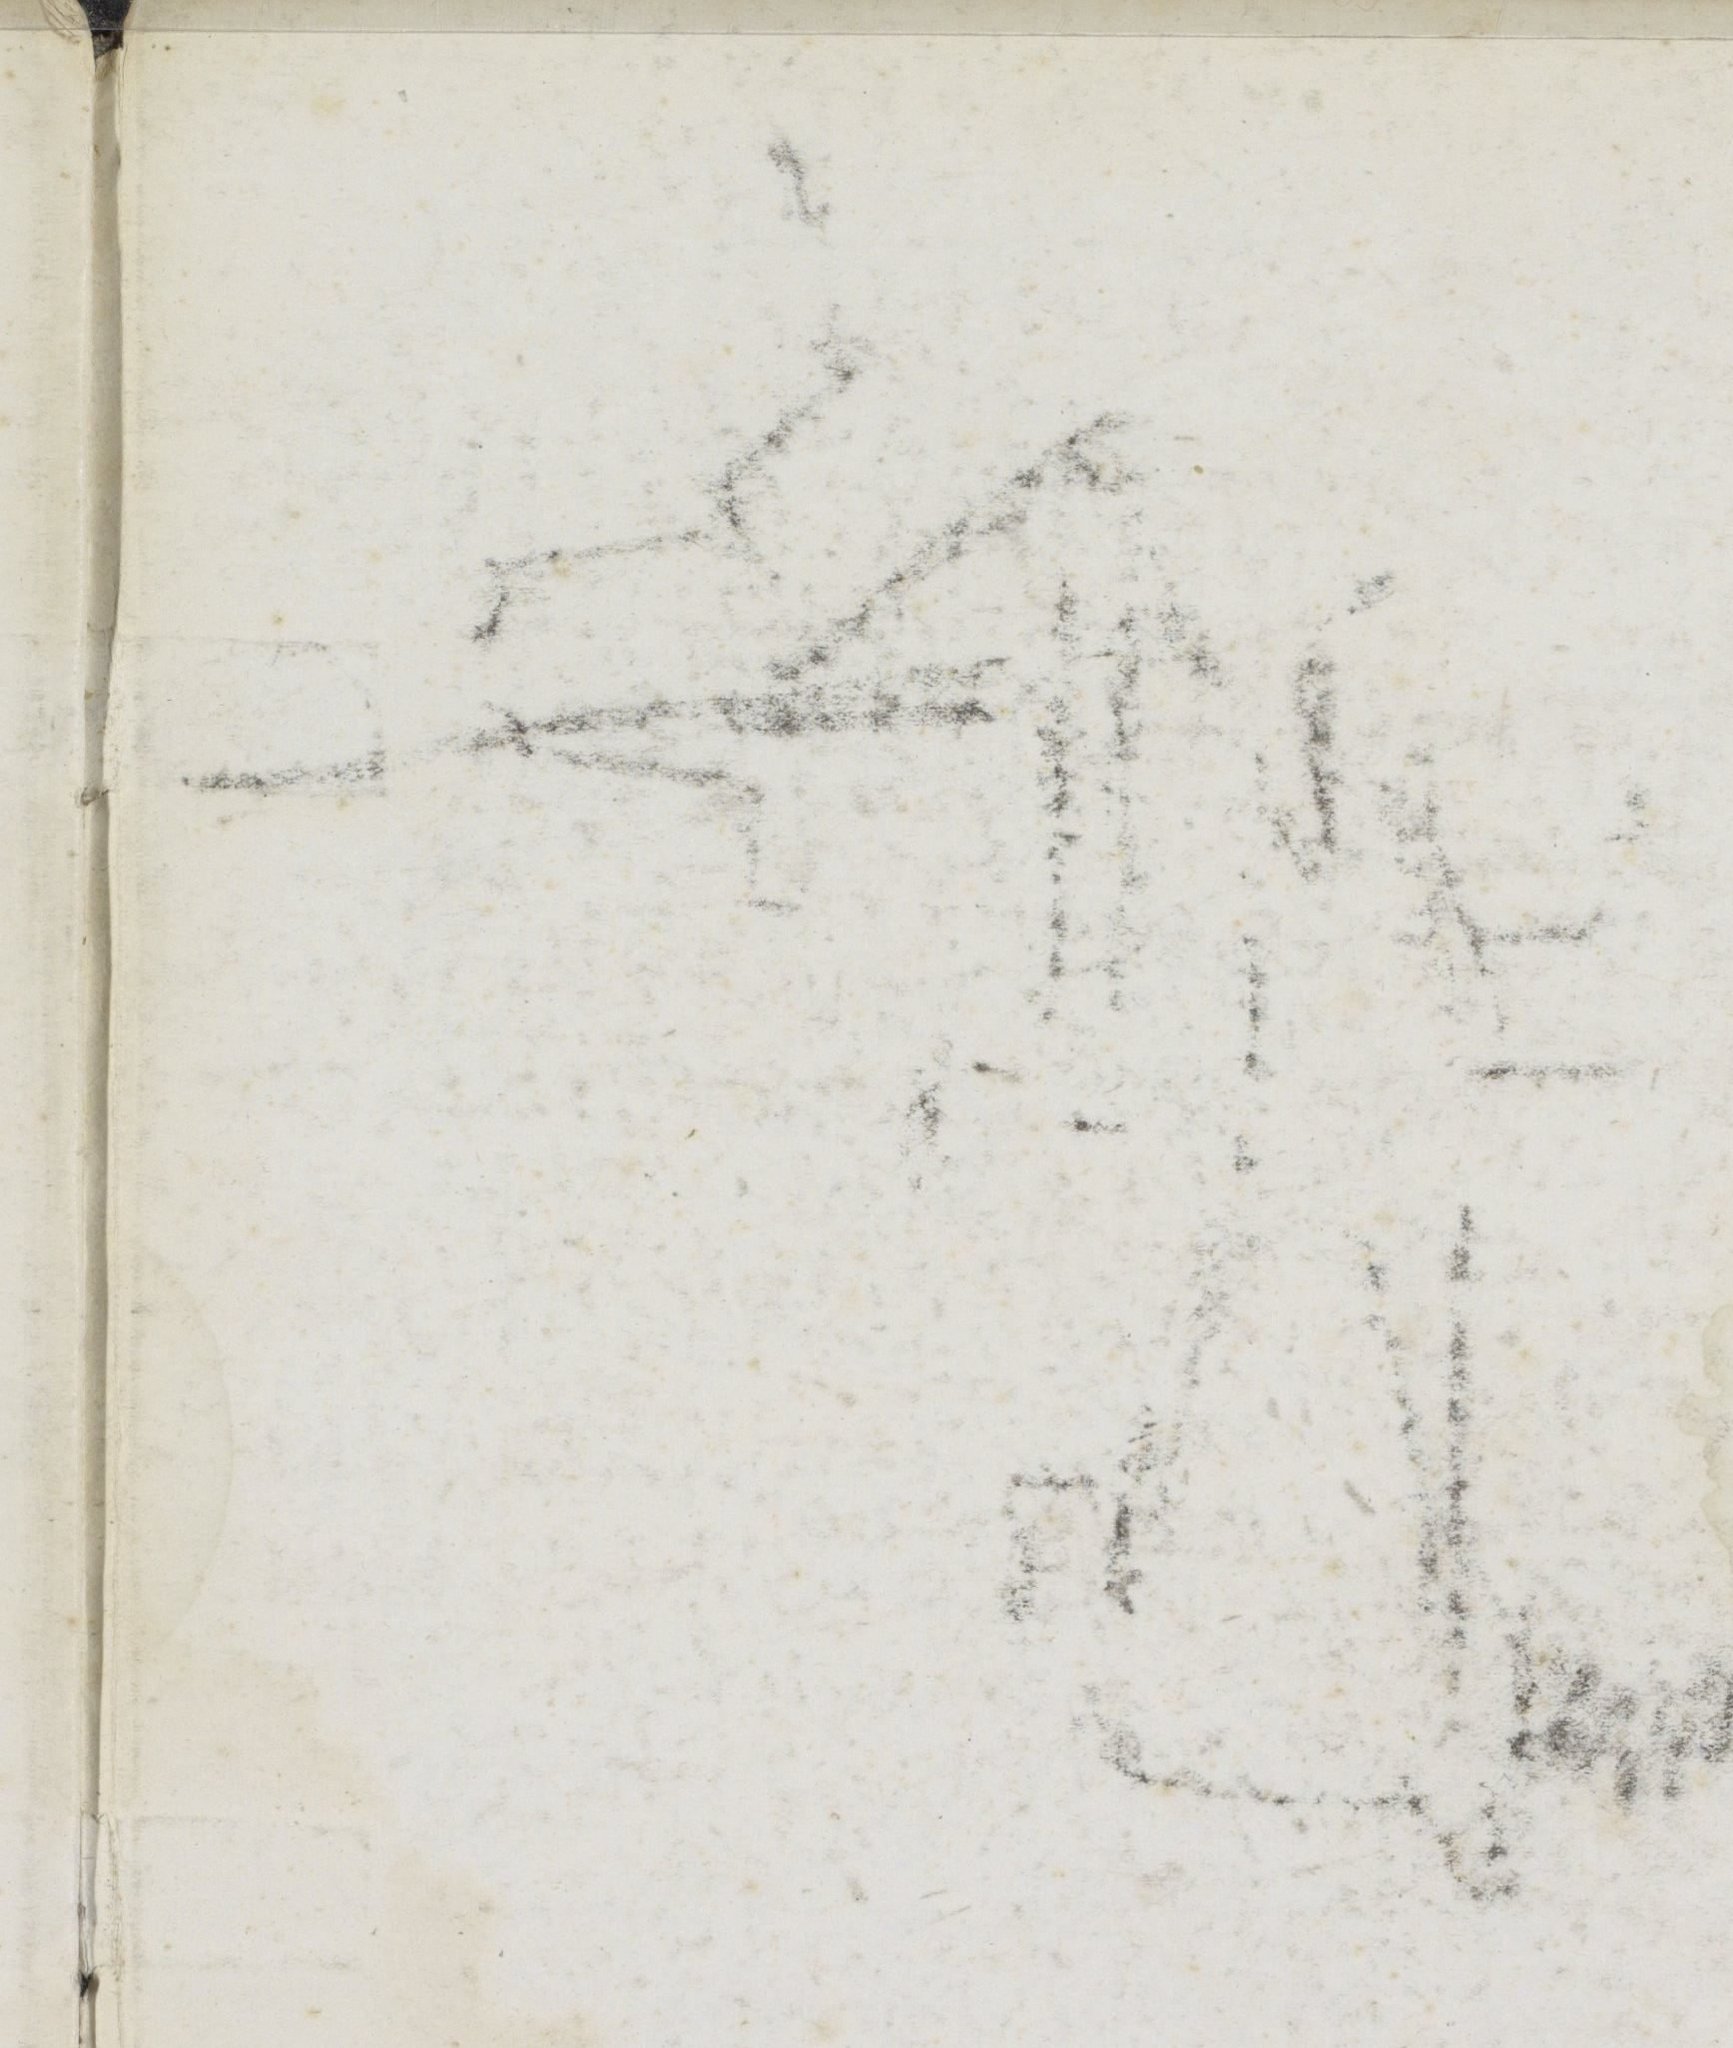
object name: sketchbook leaf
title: Annotatie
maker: george hendrik breitner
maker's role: draughtsman, painter, print maker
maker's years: 1857-1923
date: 1880-1906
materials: paper, pencil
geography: netherlands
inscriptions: number: ‘45’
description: Pagina 164, achterste schutblad, uit een schetsboek met 81 bladen.